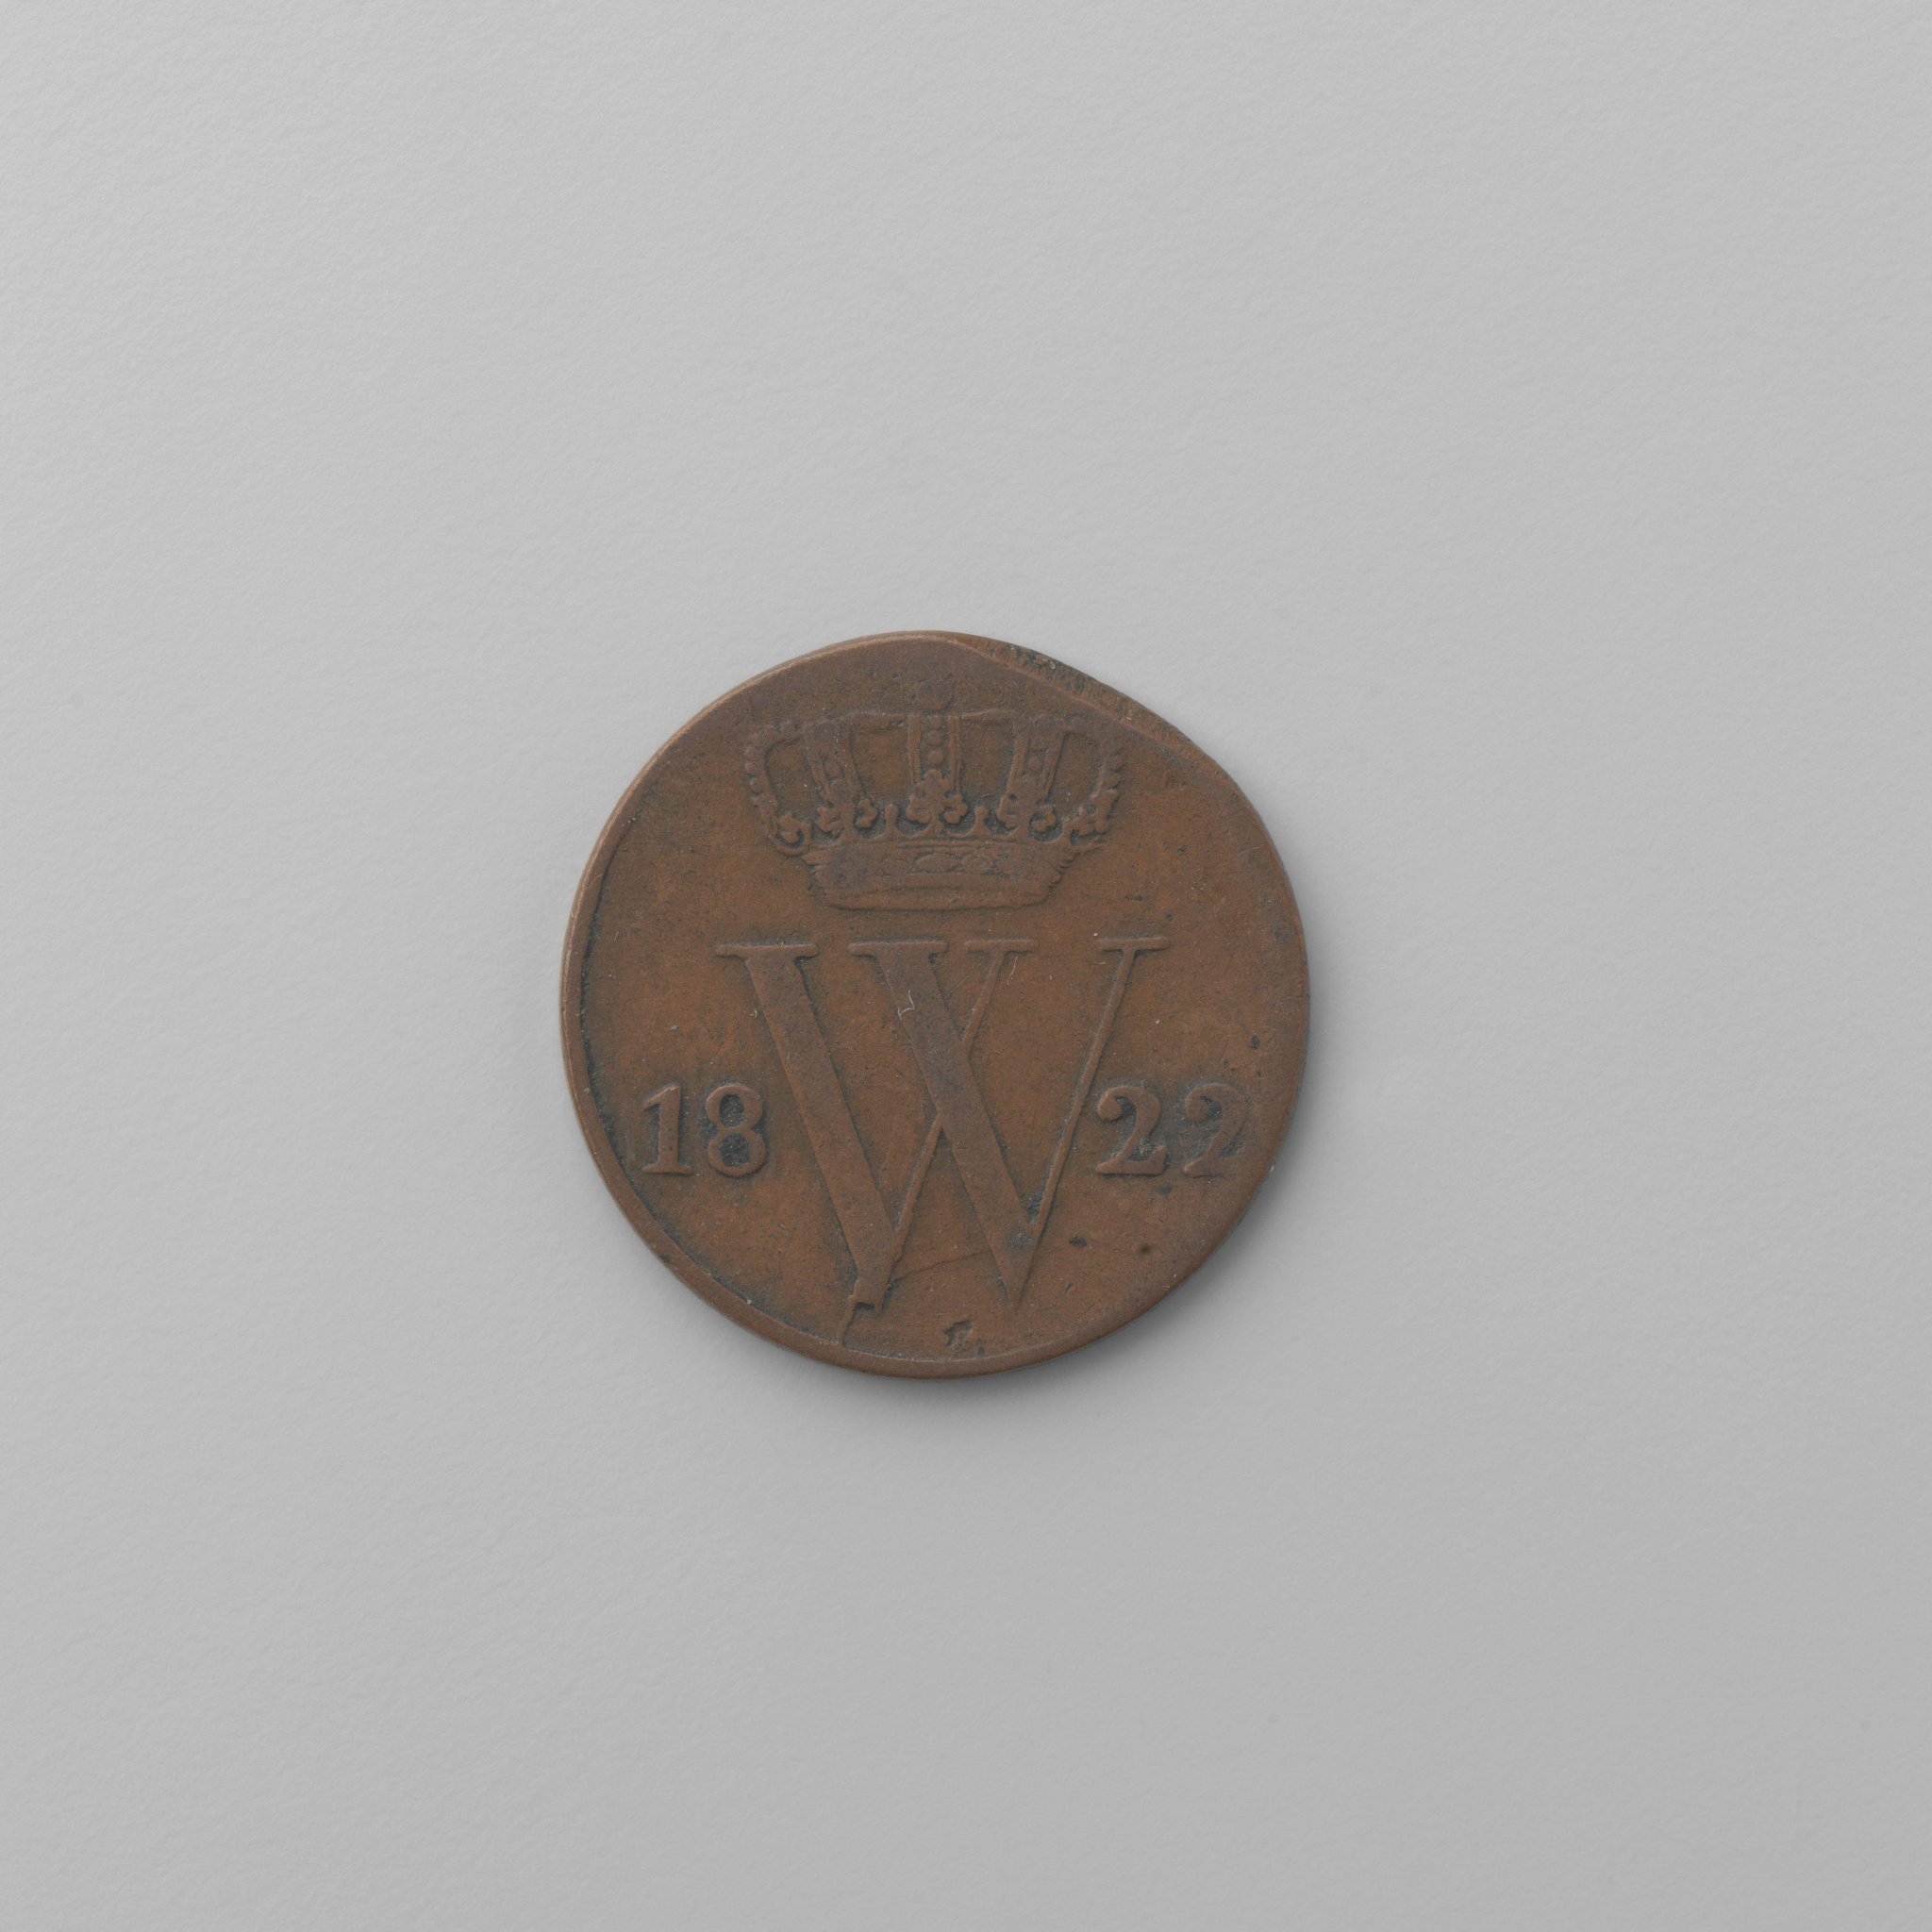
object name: coin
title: Nederlandse ½ cent,1822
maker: william i of the netherlands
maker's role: koning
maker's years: 1772-1843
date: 1822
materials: copper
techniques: striking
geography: brussels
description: Koperen munt. Voorzijde: tussen jaartal gekroonde rechte letter W. Keerzijde: tussen waarde-aanduiding ½ C. gekroond rijkswapenschild. Gladde rand.